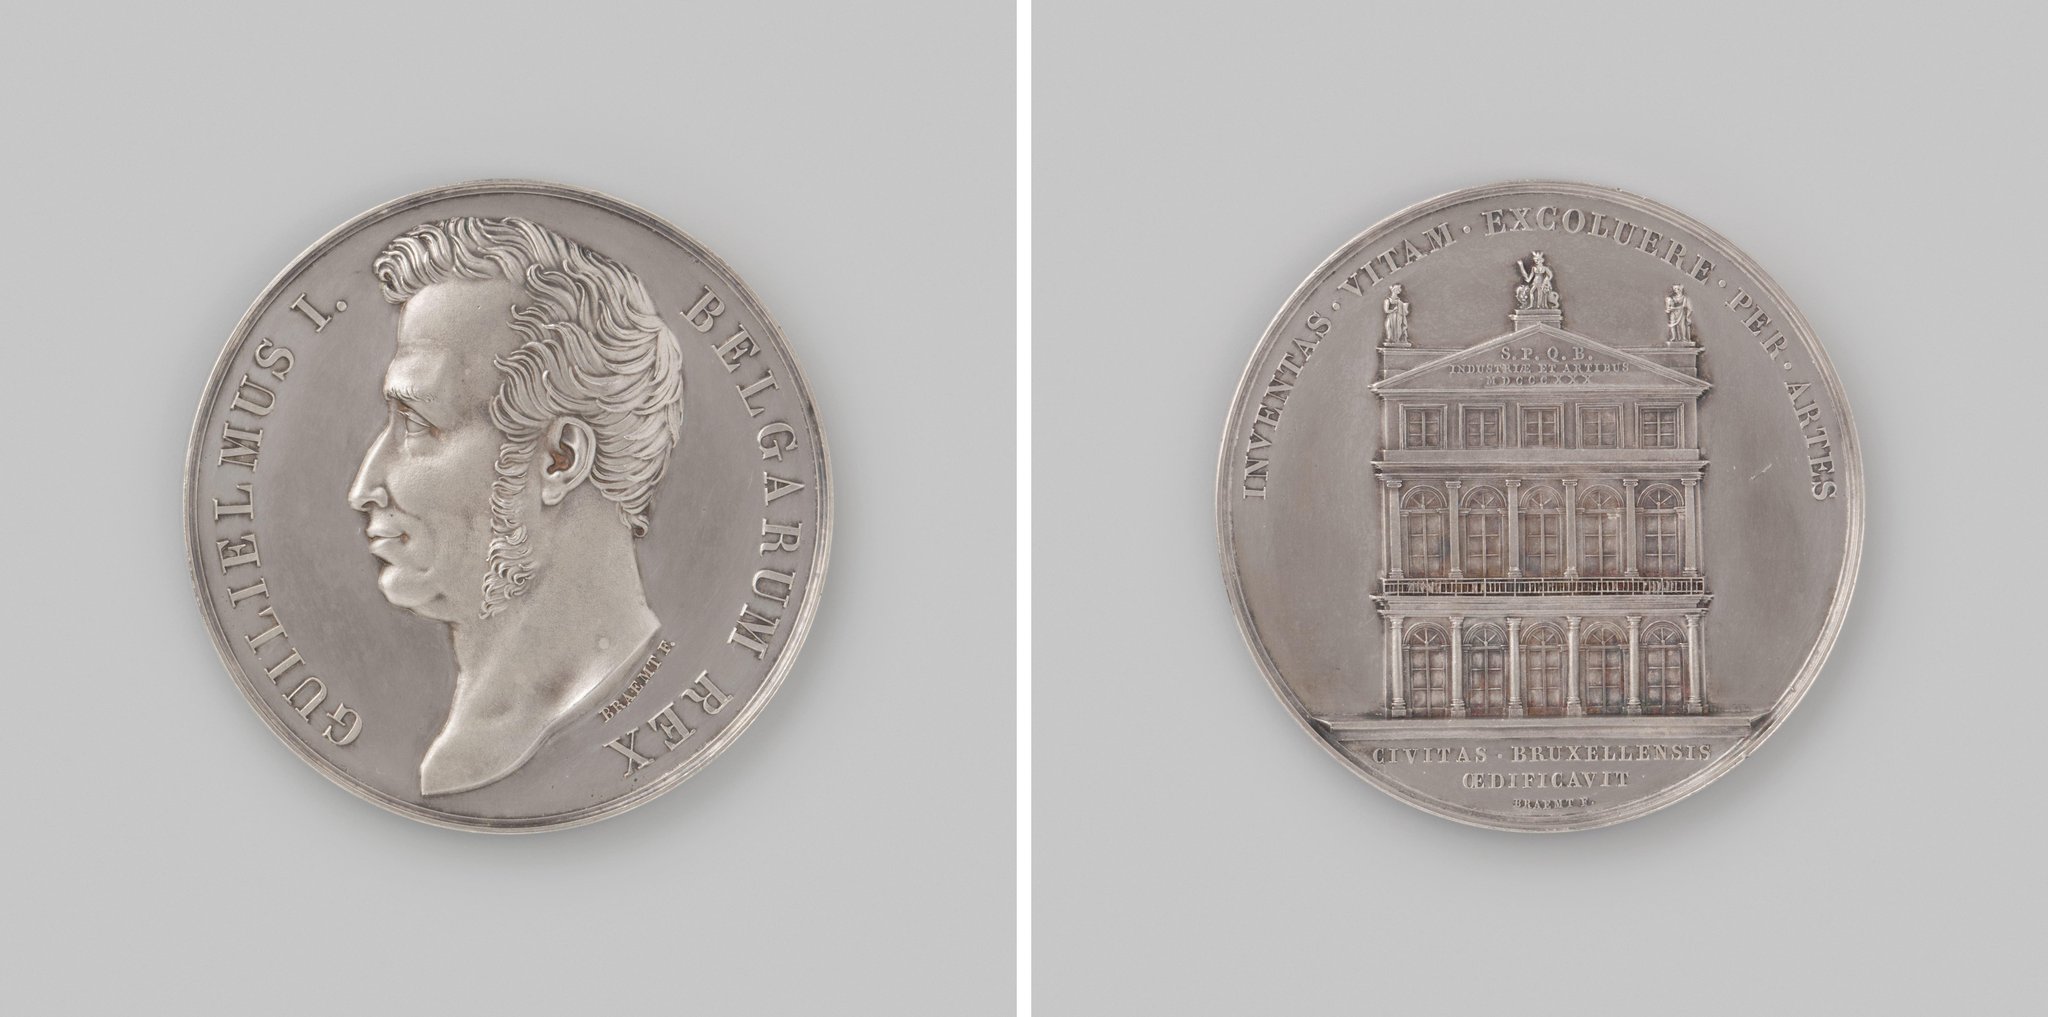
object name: medal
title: Tentoonstelling van Nijverheid te Brussel, ter ere van Willem I Frederik, koning der Nederlanden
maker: joseph pierre braemt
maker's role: print maker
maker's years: 1796-1864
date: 1830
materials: silver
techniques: striking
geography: brussels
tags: the hague, berlin, william i of the netherlands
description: Zilveren penning. Voorzijde: borststuk man binnen omschrift. Keerzijde: gedeelte van paleis van Nijverheid en Industrie binnen omschrift; afsnede: opschrift.